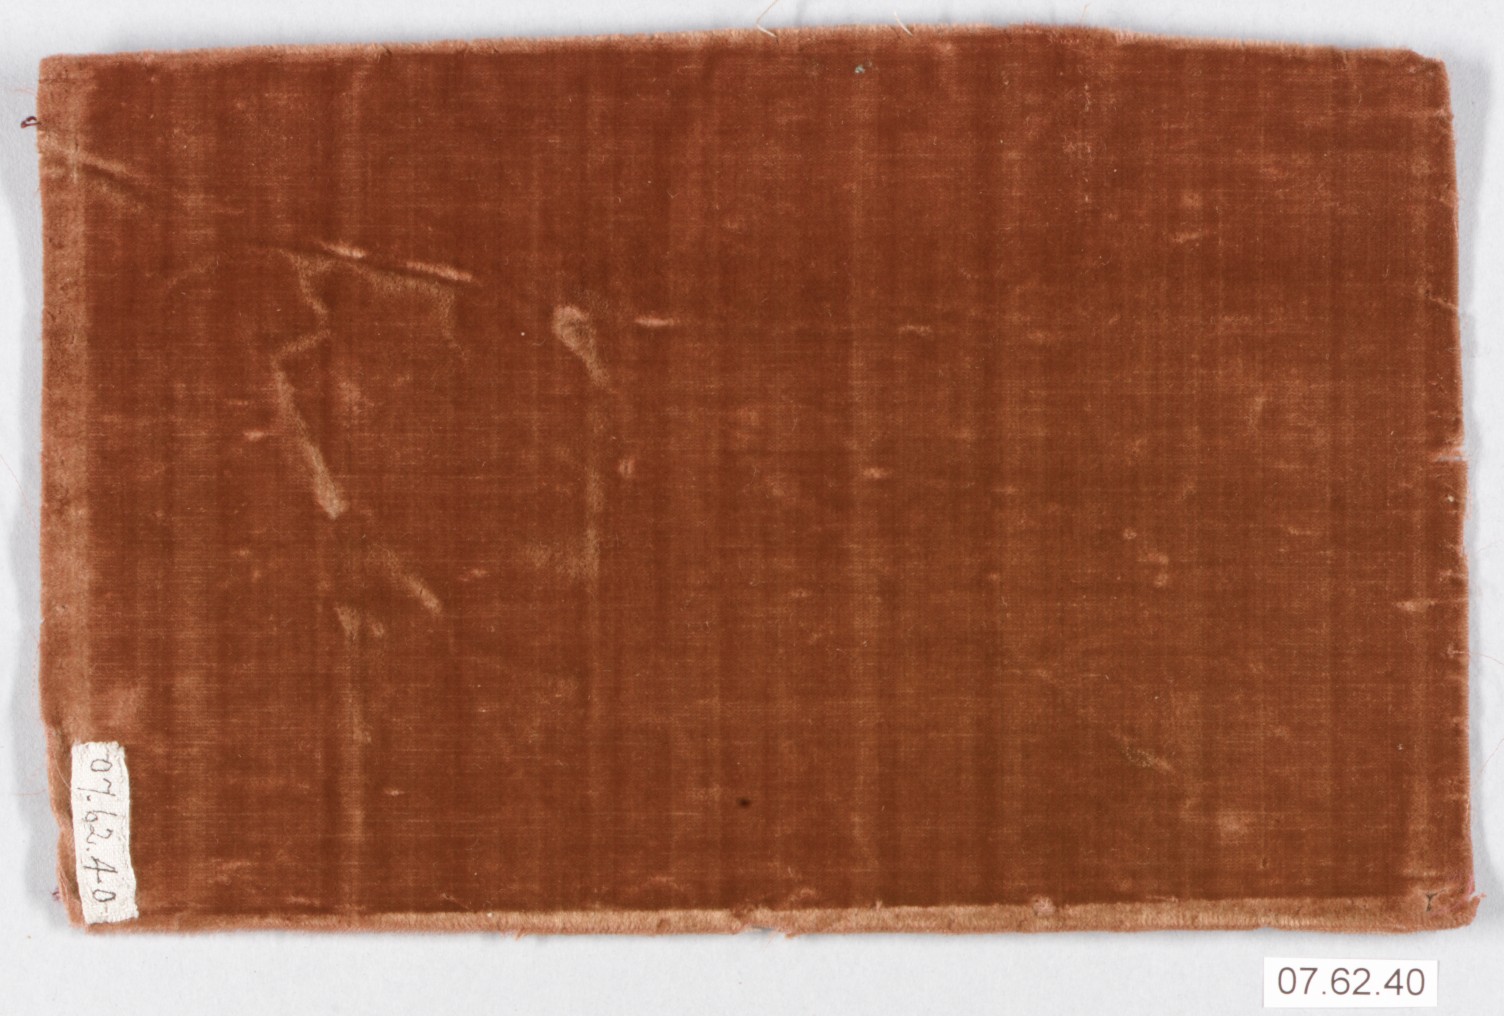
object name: fragment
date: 1501-1600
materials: silk